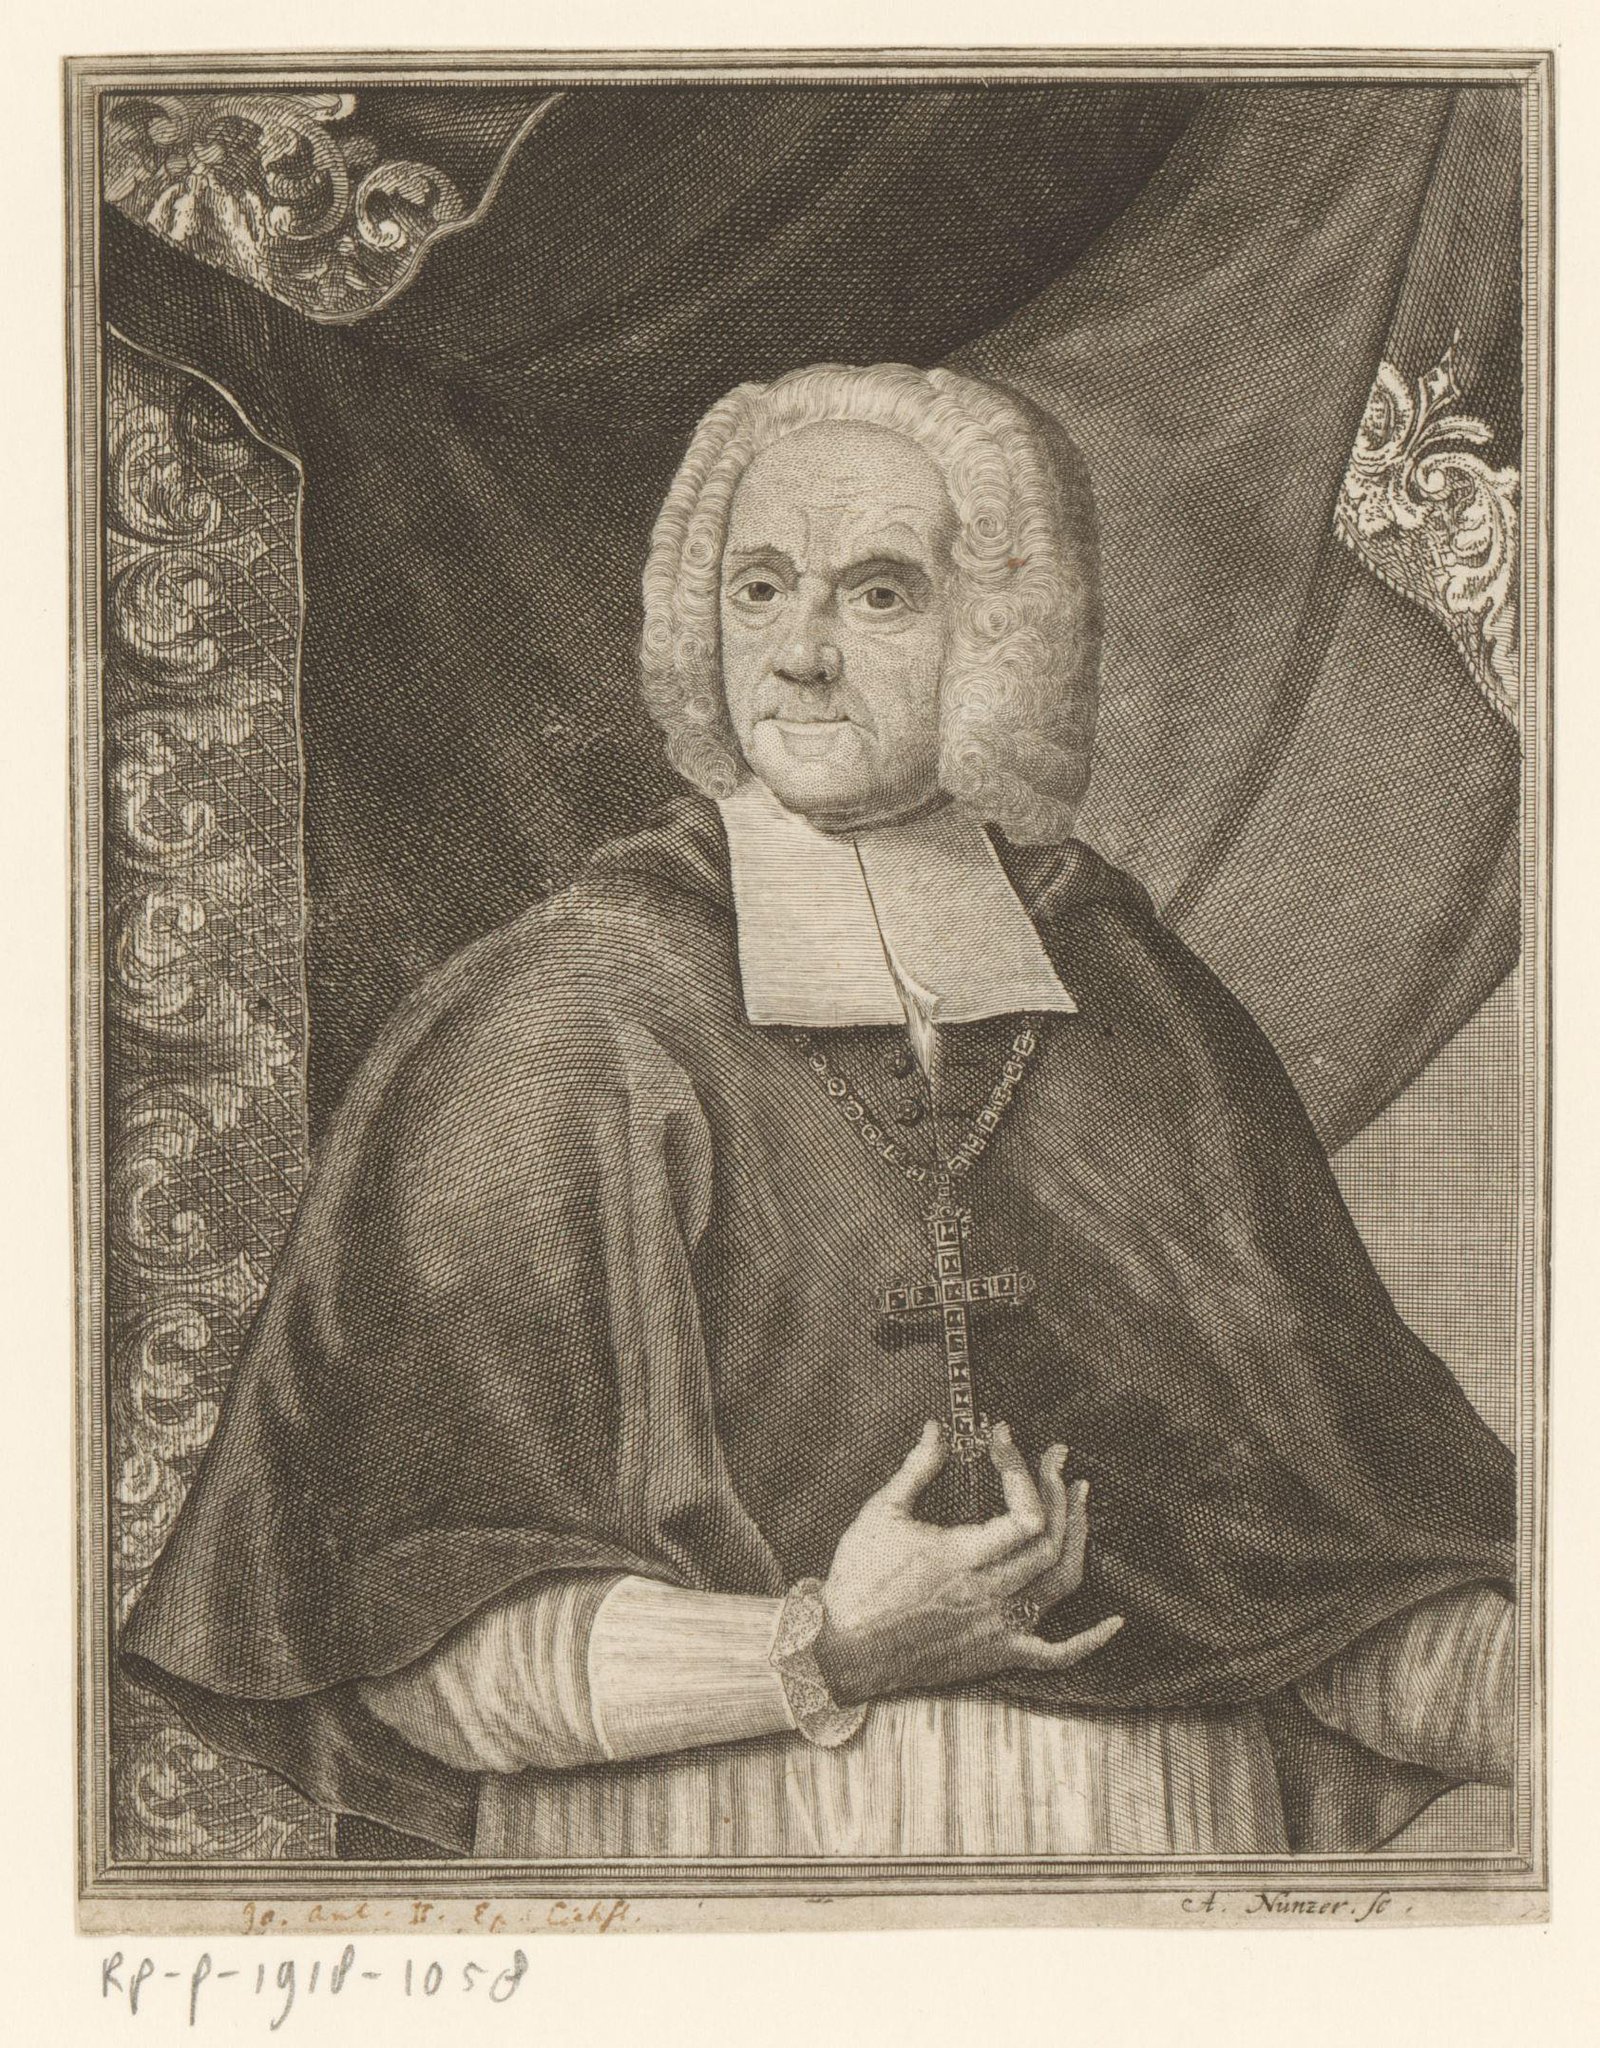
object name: print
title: Portret van Johann Anton II von Freyberg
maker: andreas nunzer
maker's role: print maker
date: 1700-1749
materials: paper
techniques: engraving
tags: eichstätt, historical persons, crucifix ~ personal devotion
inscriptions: collector's mark: Lugt 2228